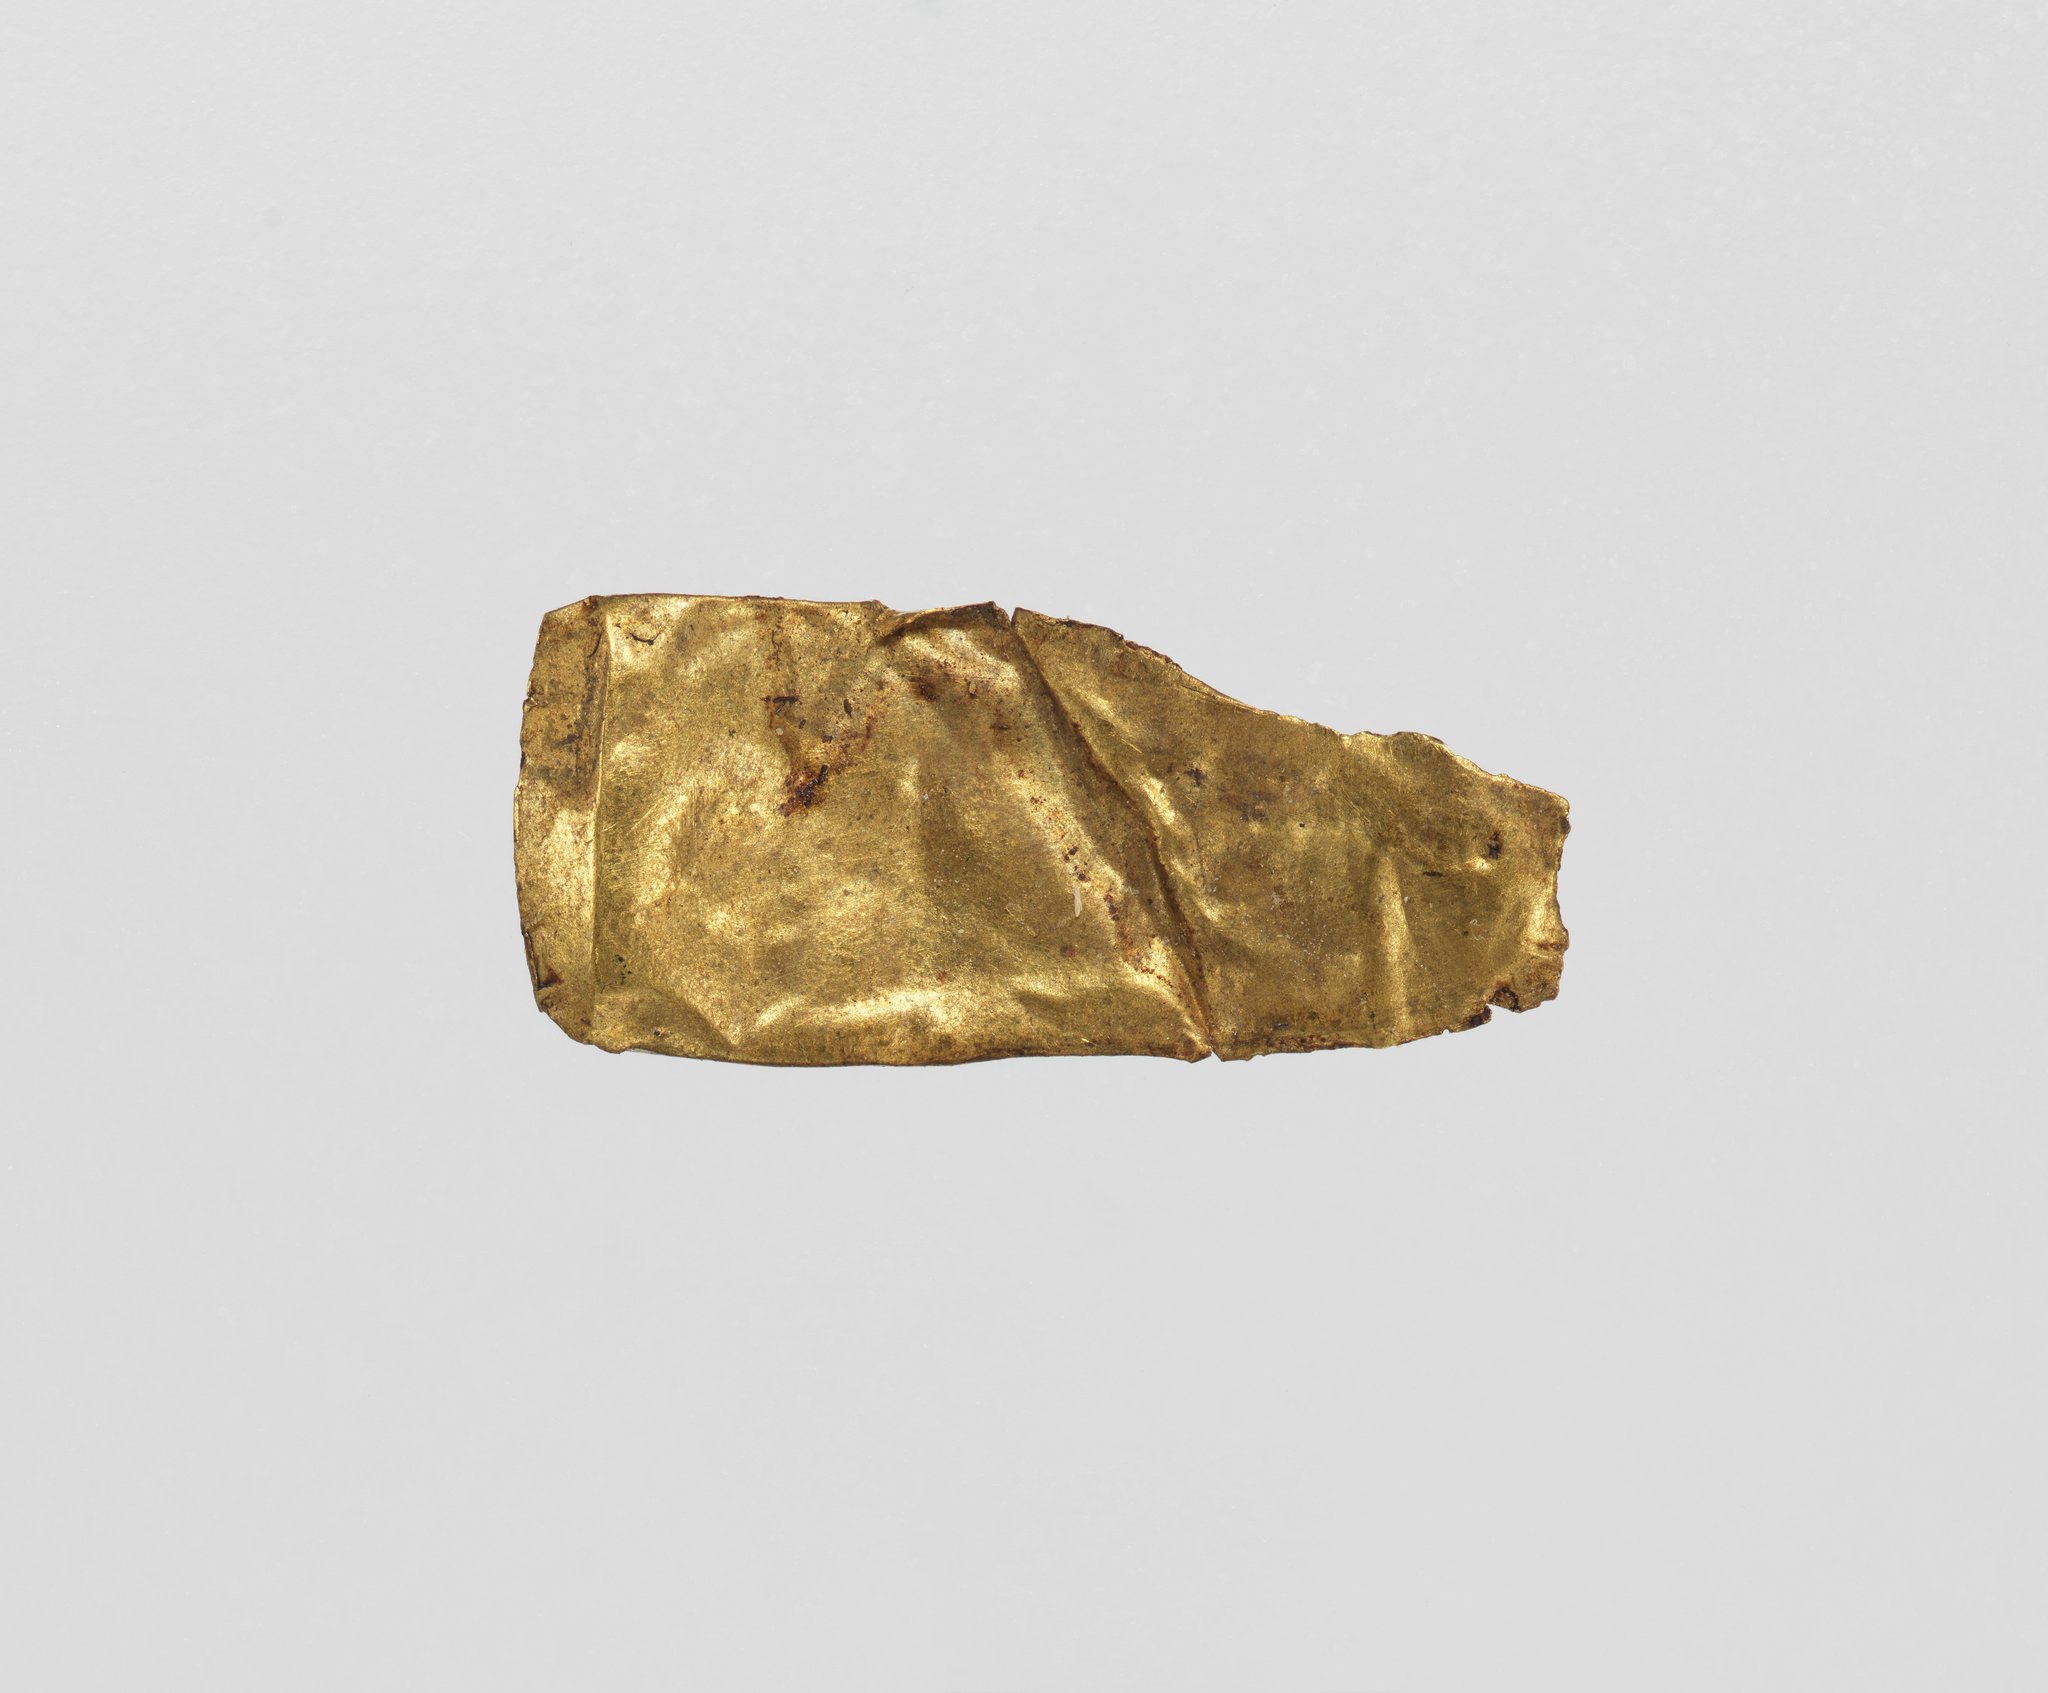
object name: amulet, mouth, isetweret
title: Mouth amulet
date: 305-30 BCE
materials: gold foil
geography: egypt